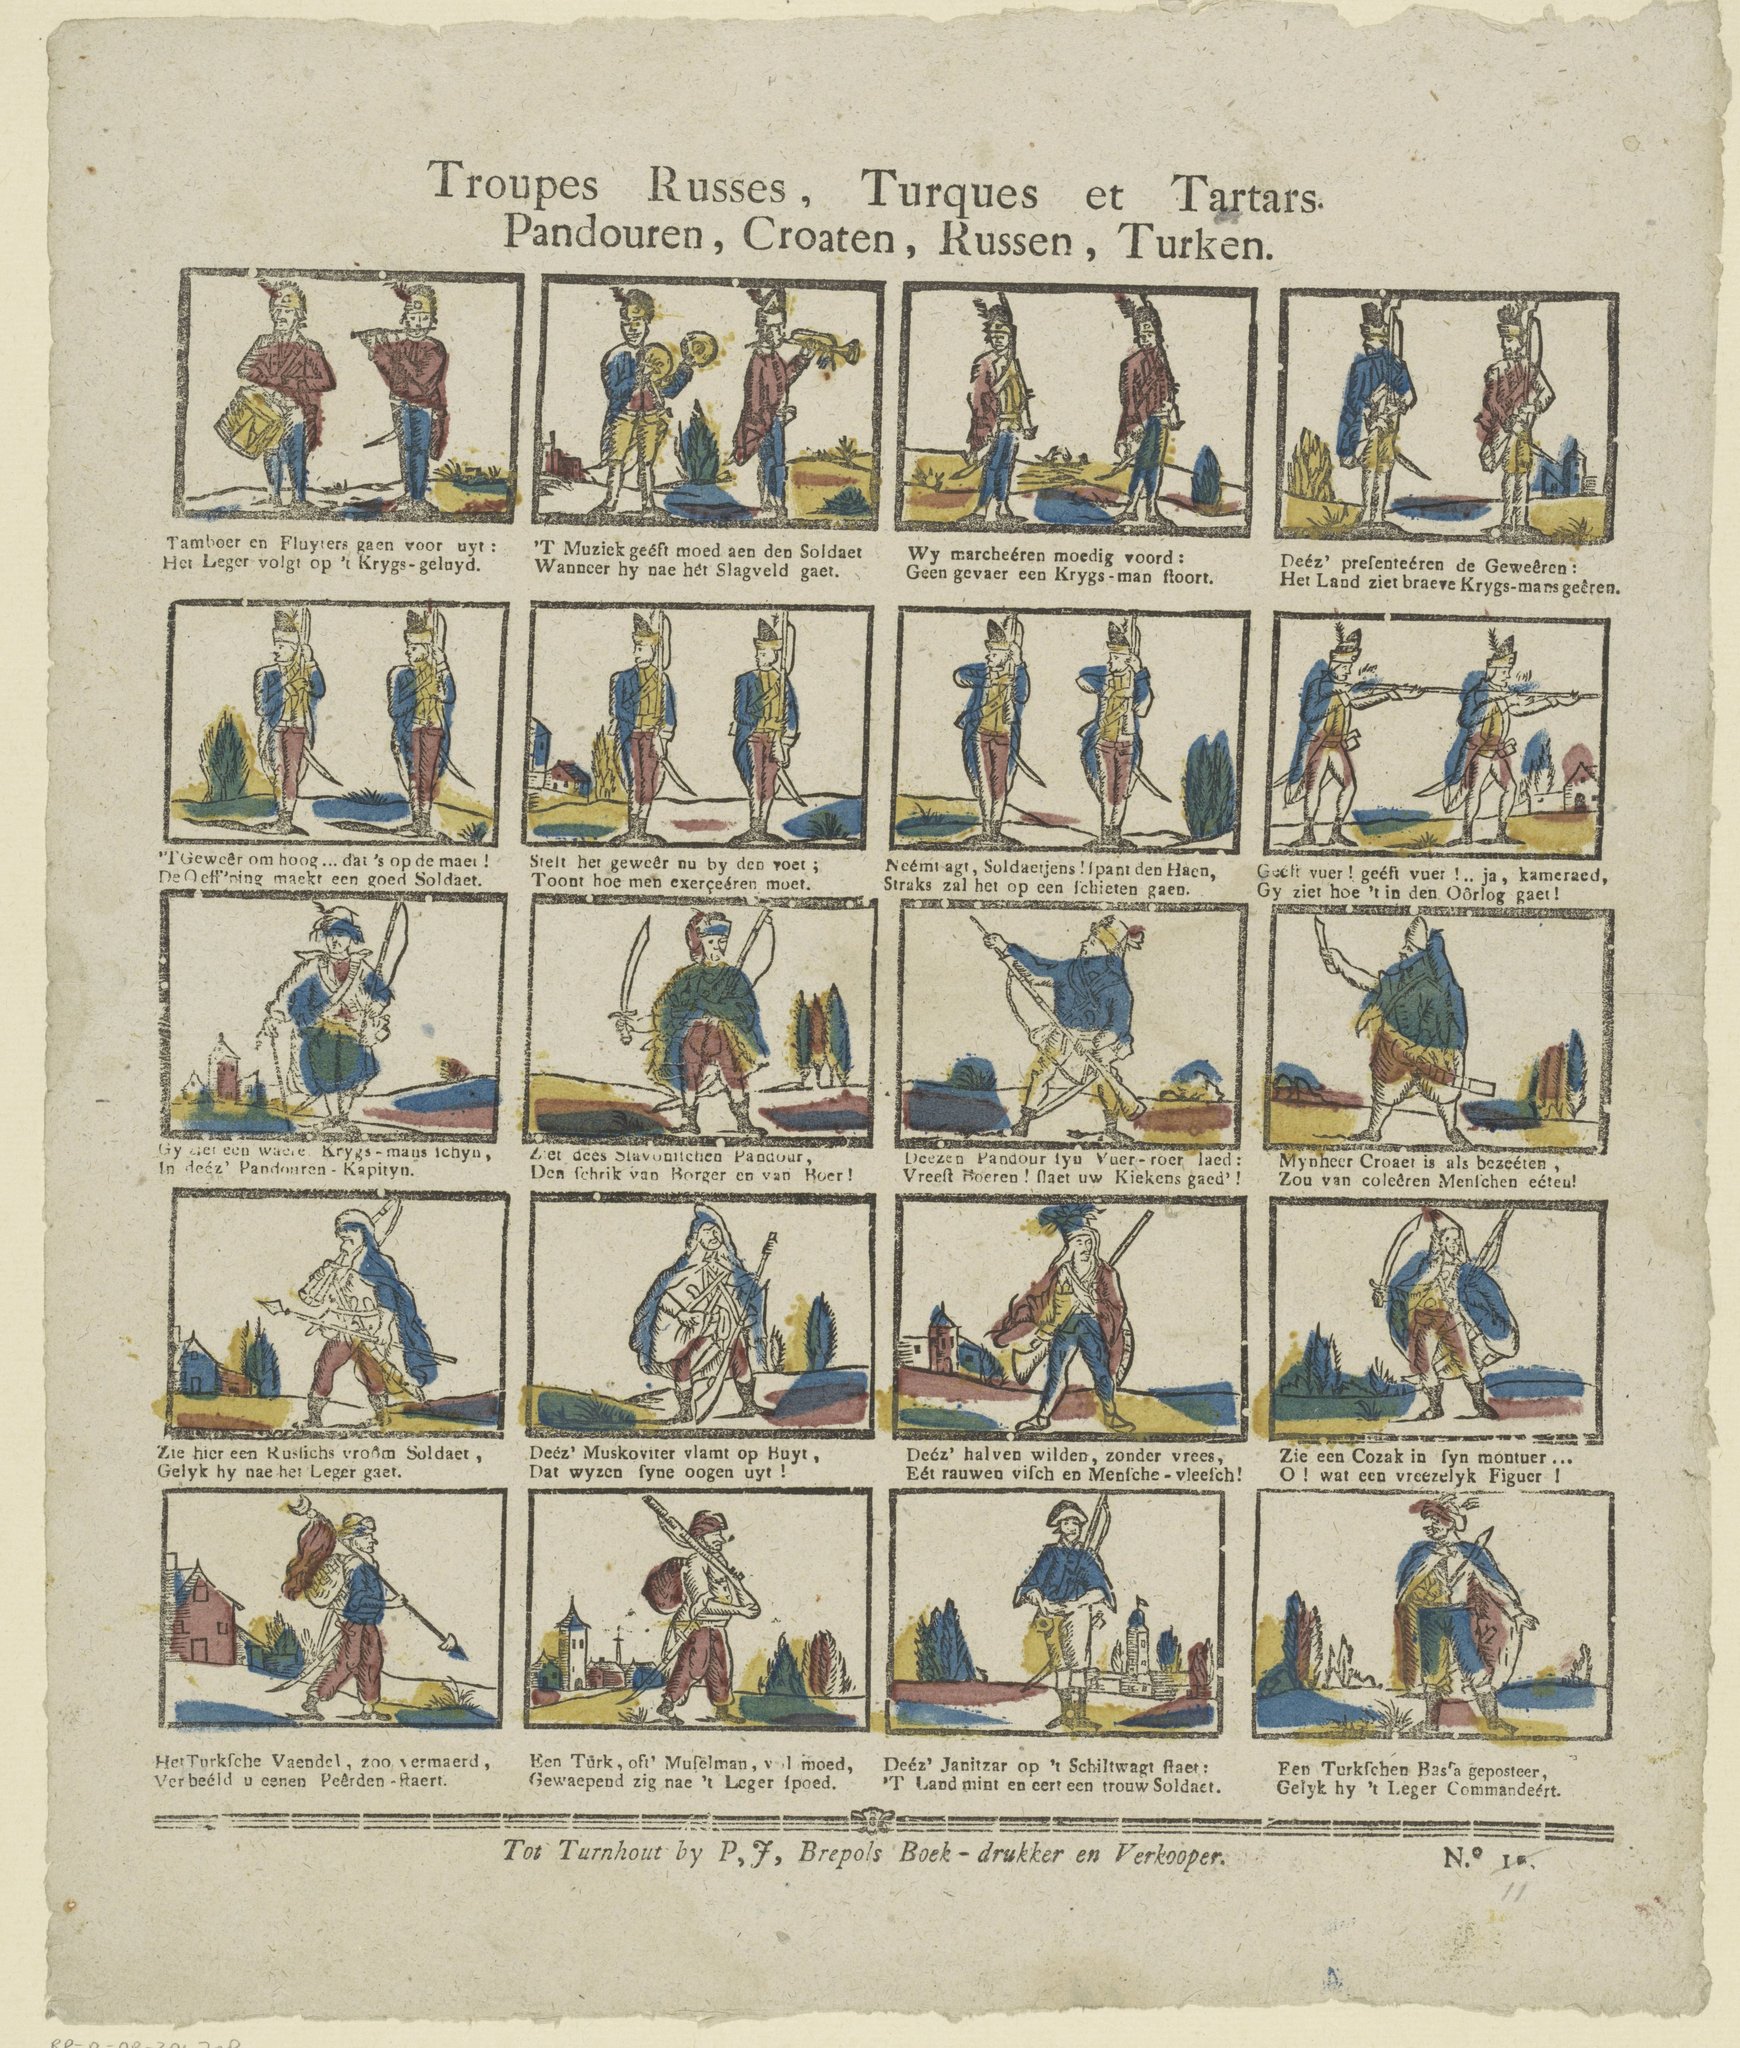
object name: popular print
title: Troupes Russes, Turques et Tartars / Pandouren, Croaten, Russen, Turken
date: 1800-1833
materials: paper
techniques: colour, letterpress printing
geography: turnhout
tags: the soldier; the soldier's life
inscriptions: collector's mark: Lugt 2760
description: Blad met 20 voorstellingen van militairen. Onder elke afbeelding een tweeregelig vers in het Nederlands. Genummerd rechtsonder: No. 12.